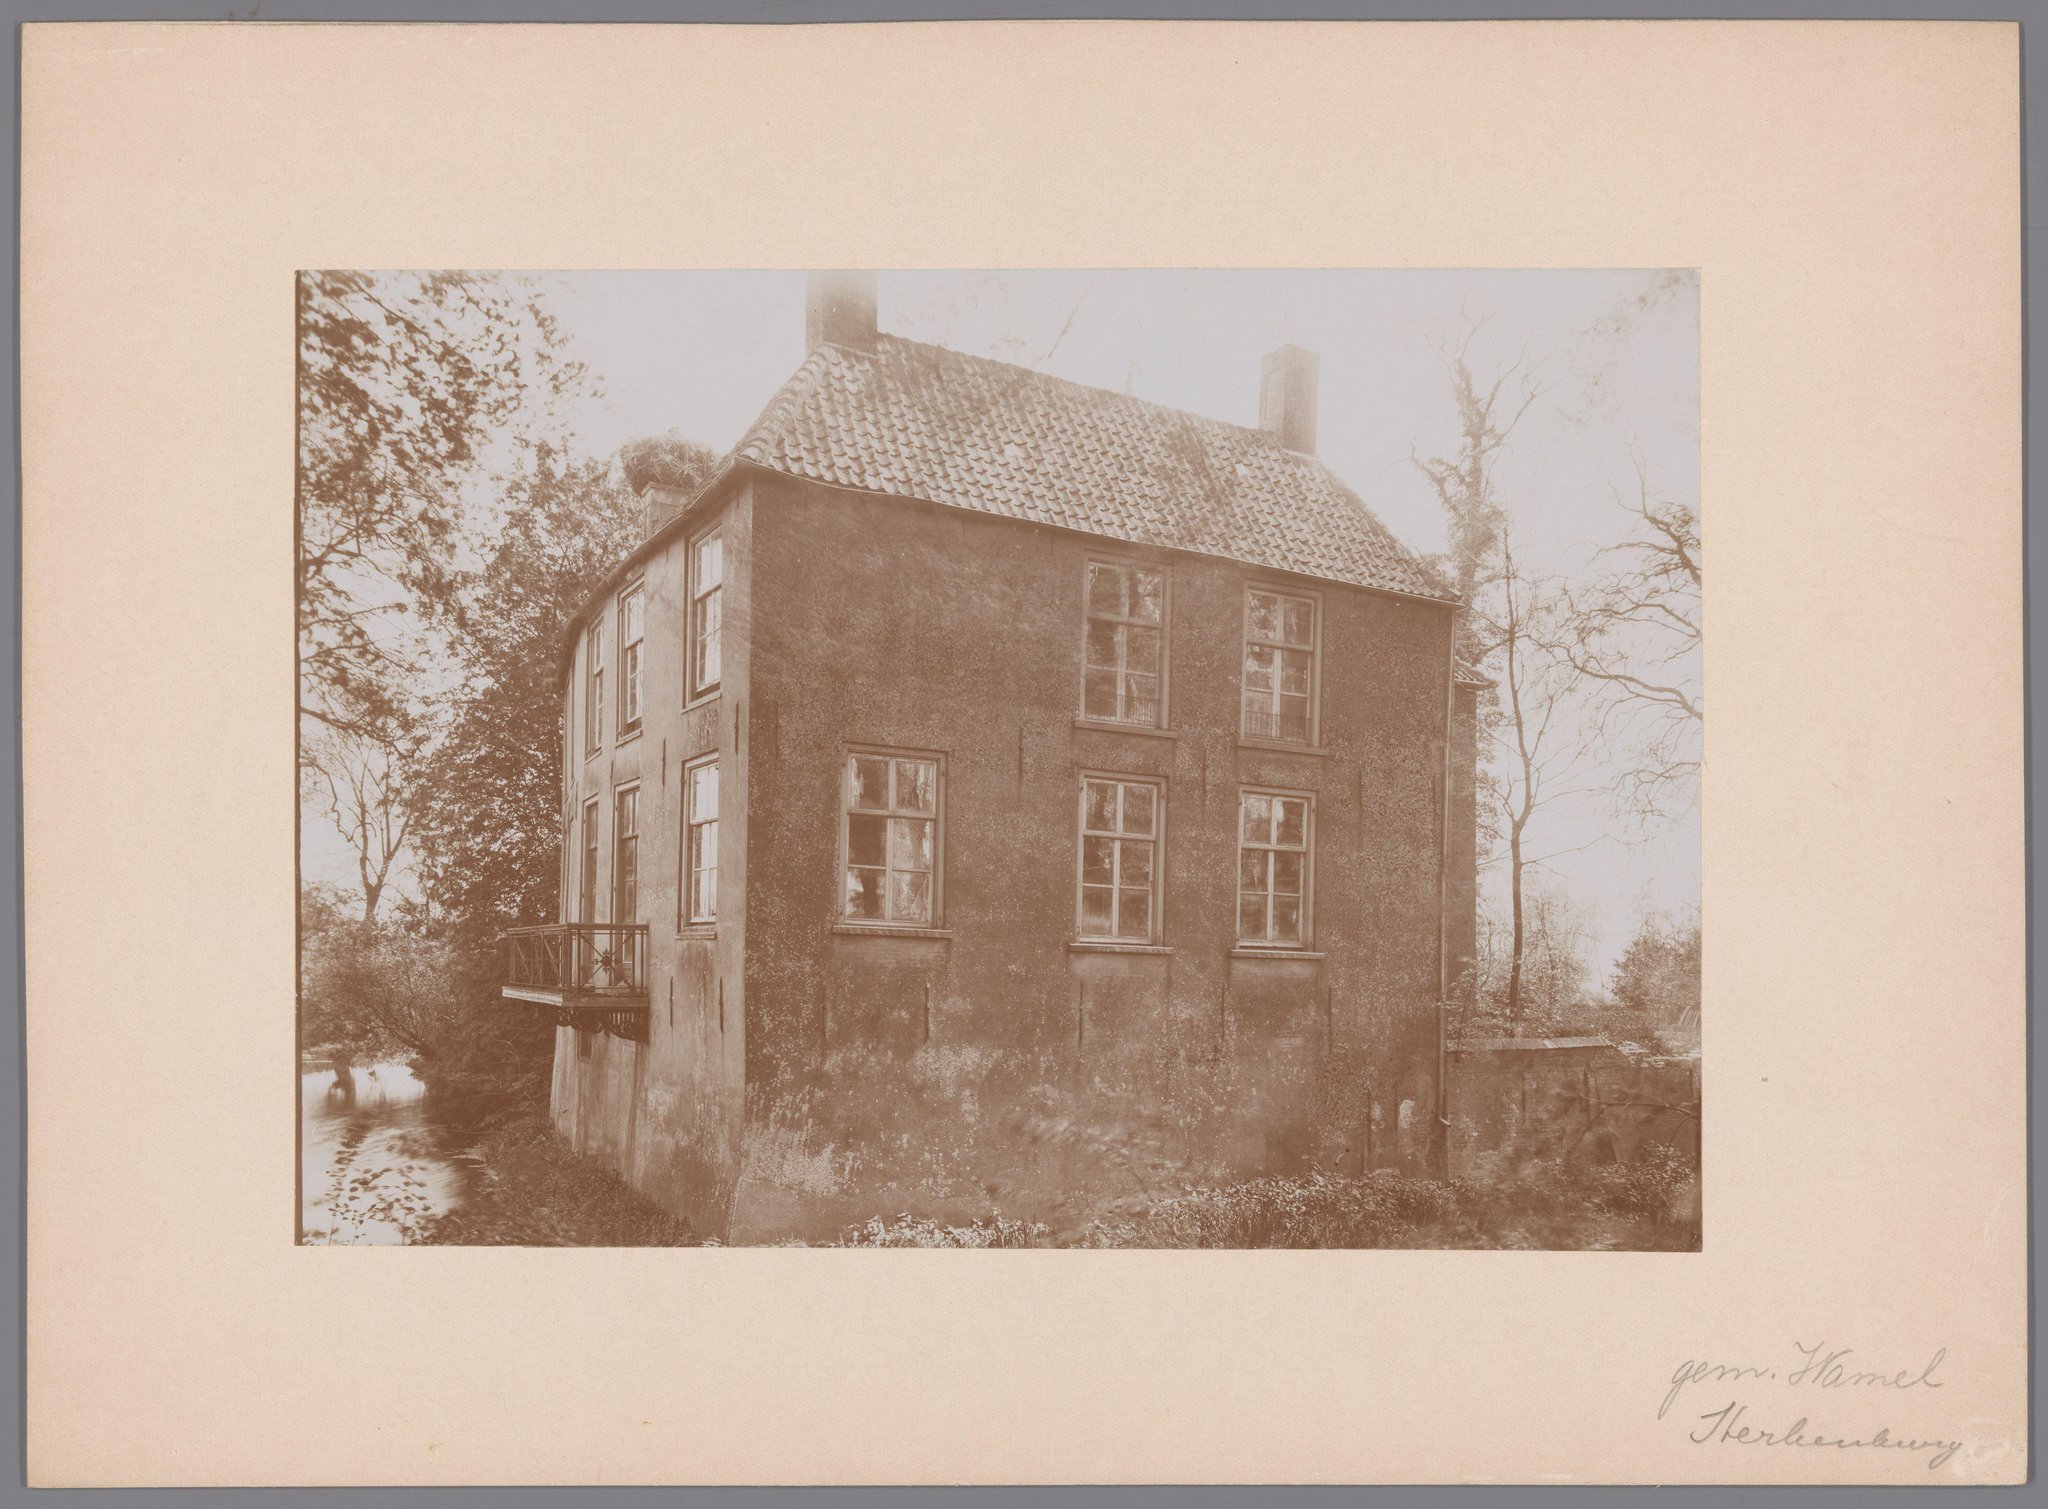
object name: photograph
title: Gezicht op Kasteel Sterkenburg te Wamel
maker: anoniem (monumentenzorg)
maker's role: fotograaf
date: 1905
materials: cardboard, photographic support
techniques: collodion silver print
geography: wamel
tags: castle, landscape with tower or castle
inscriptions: annotation: ‘gem. Wamel/ Sterkenburg’, annotation: ‘Huize Serkenburg (G.)/ onder de gemeente Wamel bij Tiel/ Mei 1905’